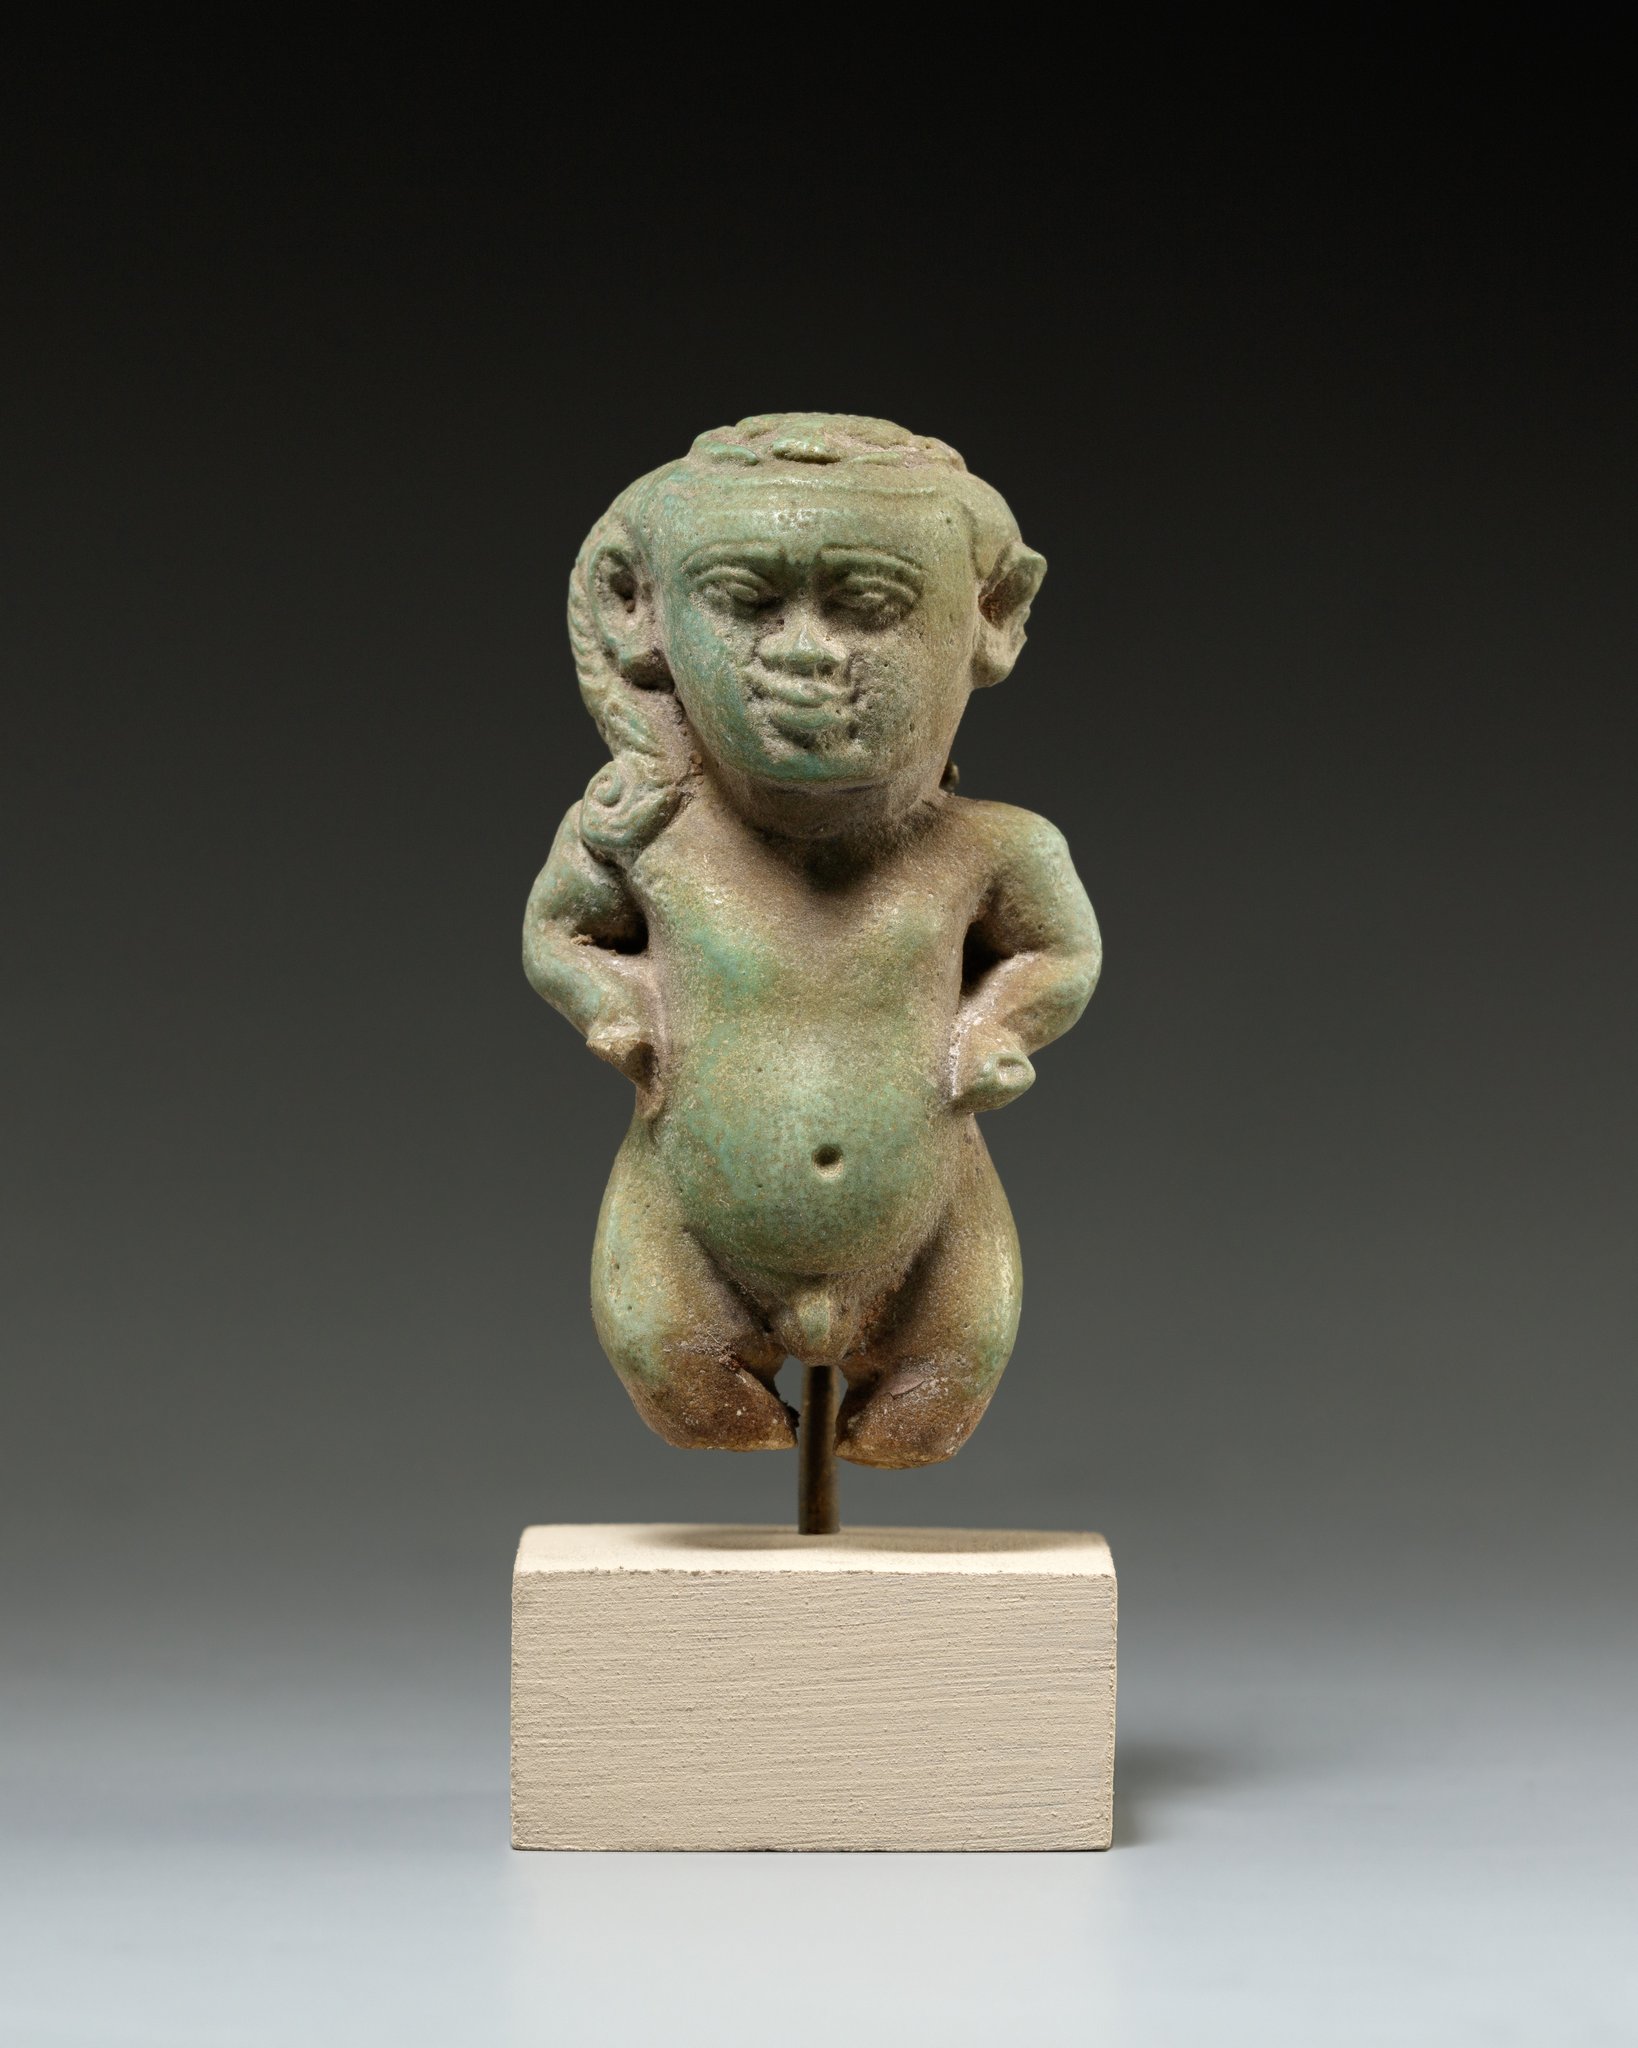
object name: amulet, patakios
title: Pataikos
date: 664-630 BCE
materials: faience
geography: egypt